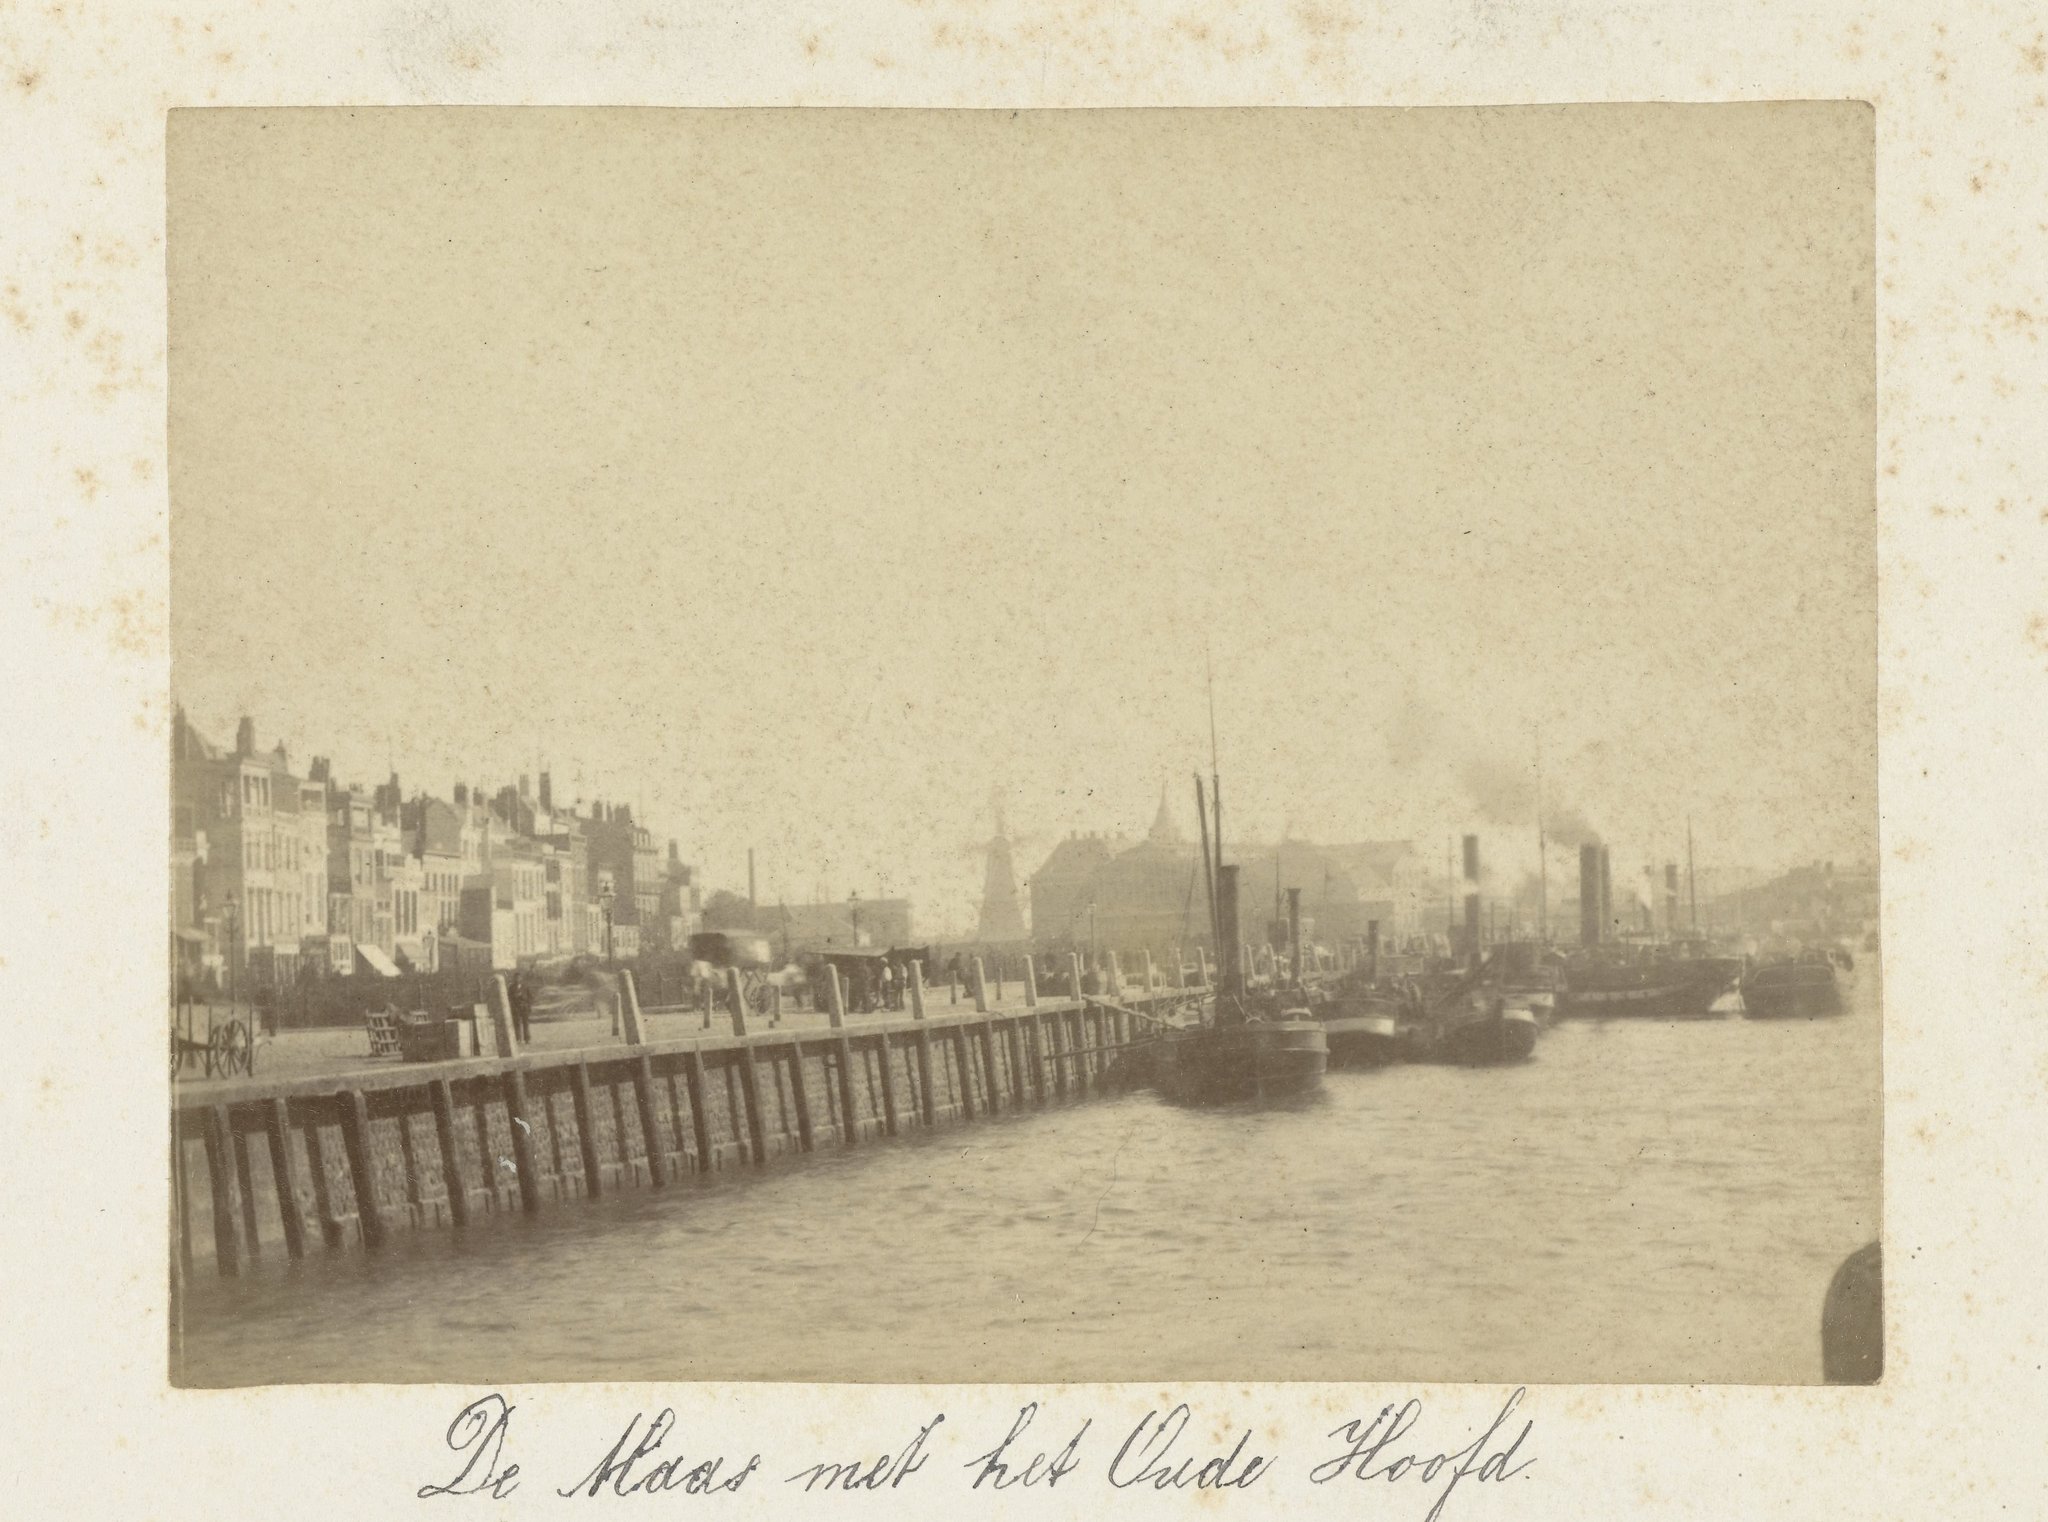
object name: photograph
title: Gezicht over de Maas met in de haven een aantal stoomschepen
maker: Anonymous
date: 1880-1900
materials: paper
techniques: albumen print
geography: netherlands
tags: city-view, and landscape with man-made constructions, river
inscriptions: title: ‘De Maas met het Oude Hoofd’